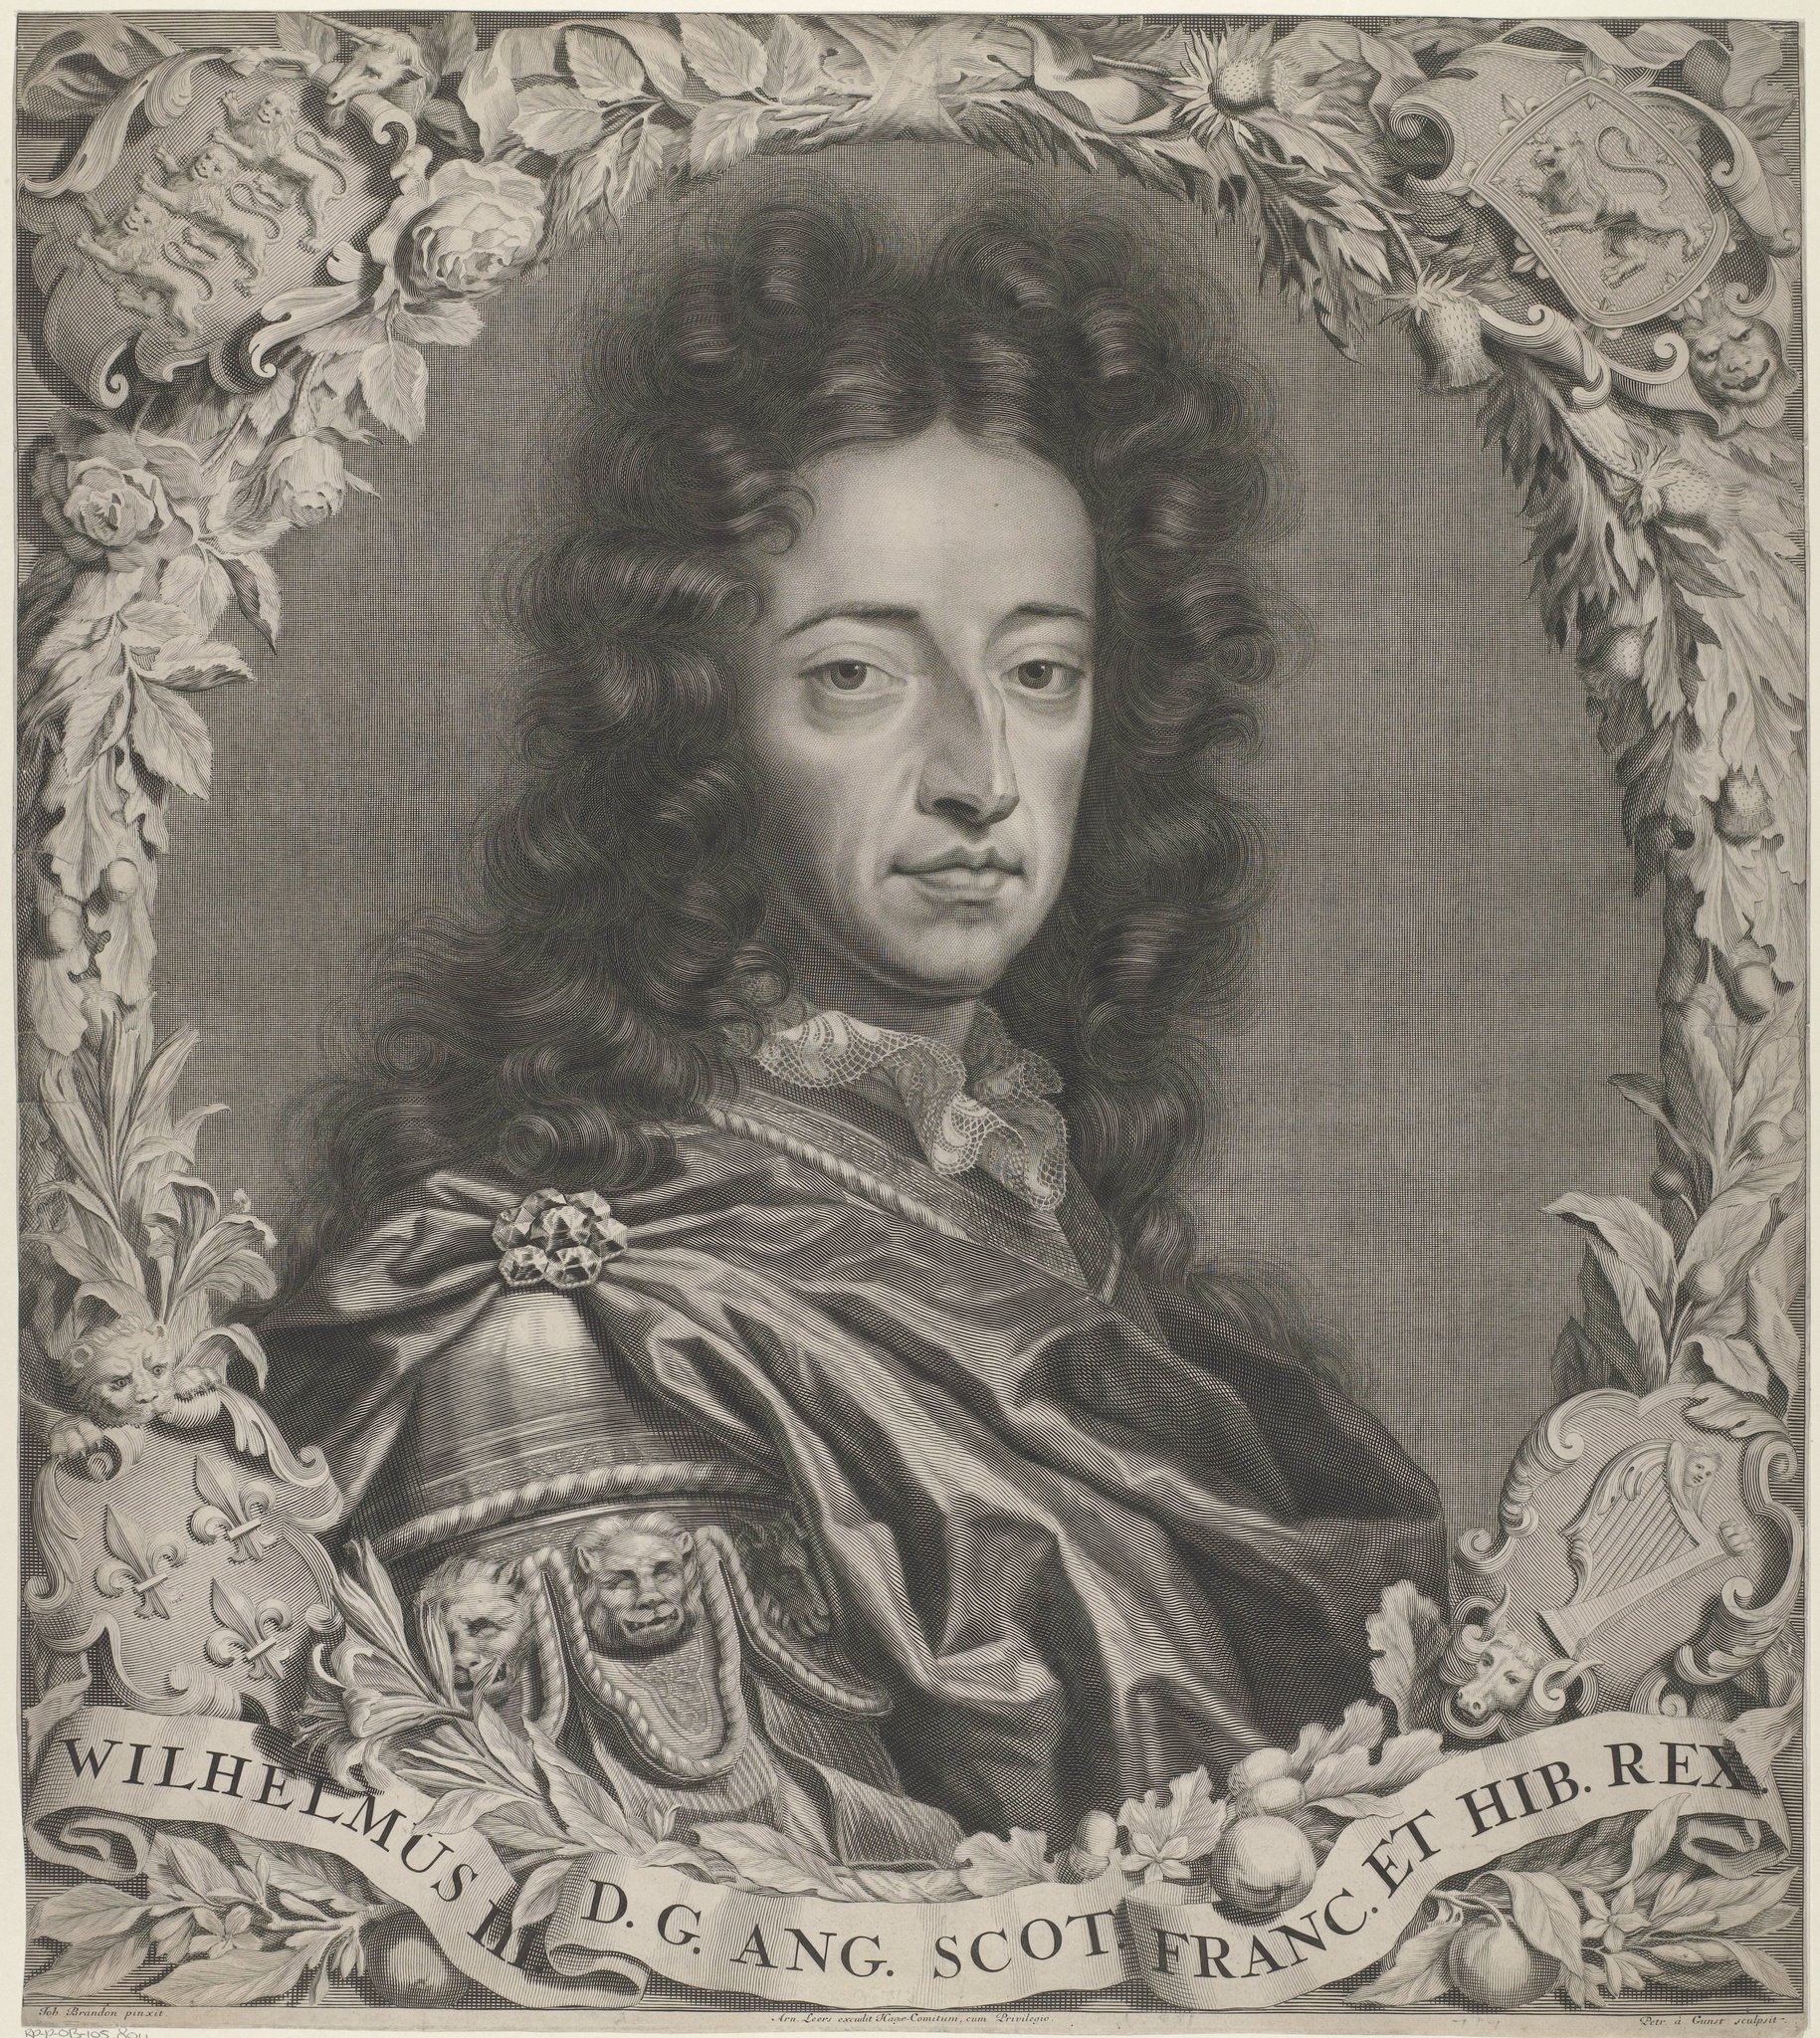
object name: print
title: Portret van Willem III, prins van Oranje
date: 1694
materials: paper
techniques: engraving, etching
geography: northern netherlands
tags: the hague, william iii (prince of orange and king of england, scotland, and ireland), prince, historical persons, armorial bearing, heraldry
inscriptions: collector's mark: Lugt 963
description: De hier vermelde titel verwijst naar de hoogst verkregen titel van de geportretteerde, niet per se naar de titel die de geportretteerde op deze voorstelling draagt.